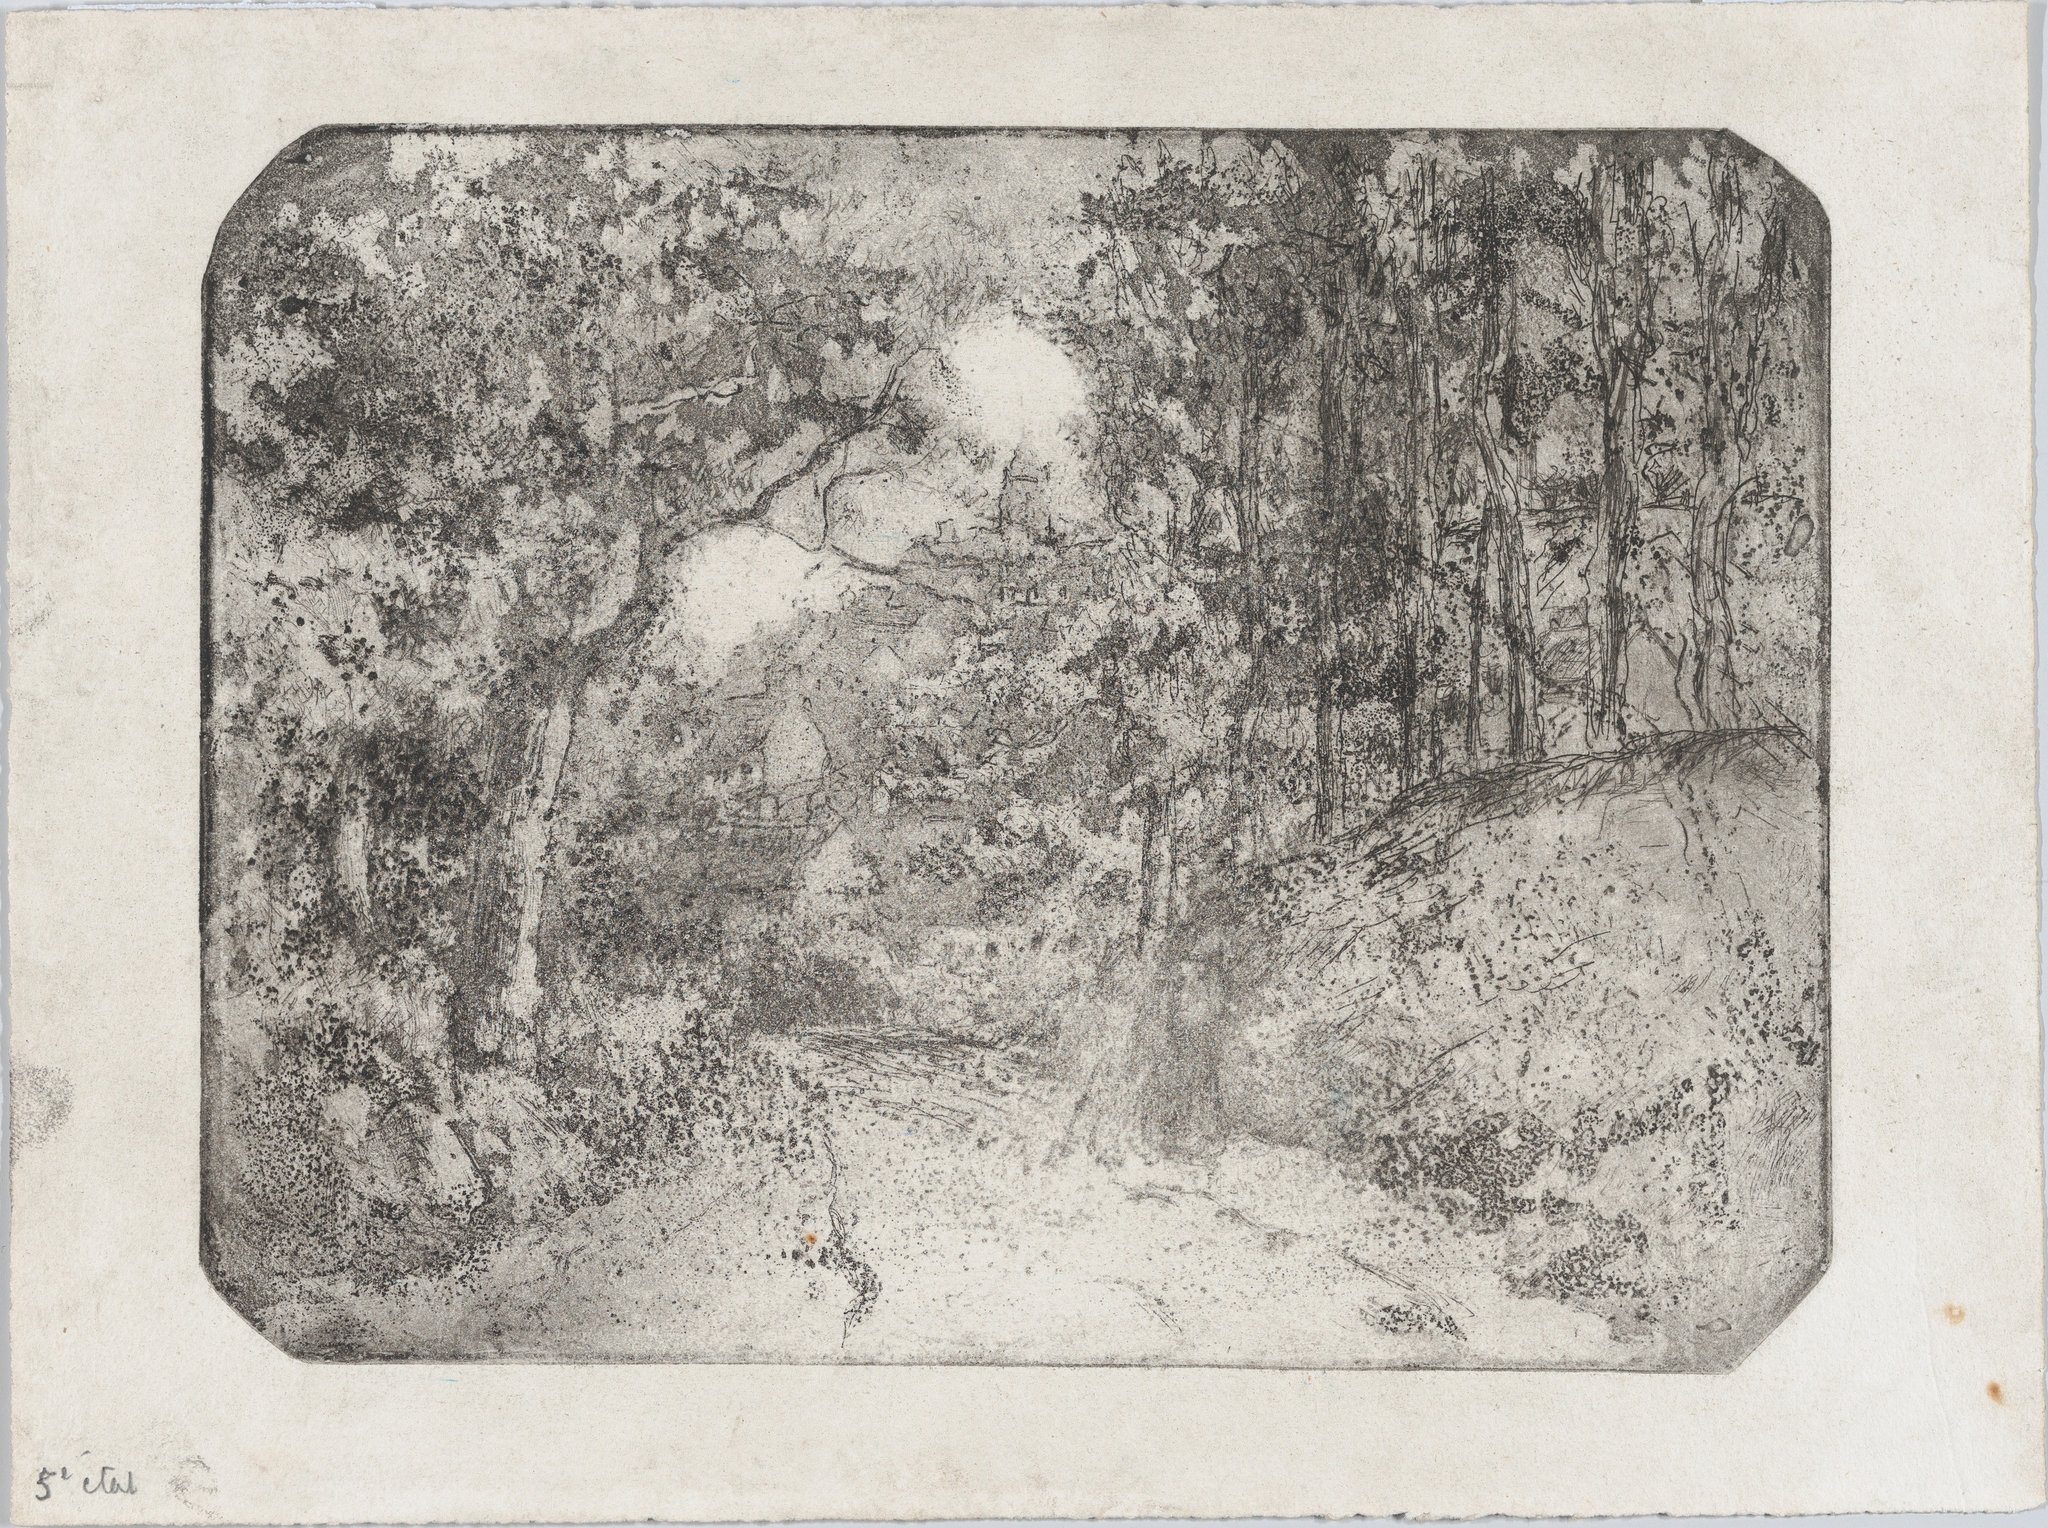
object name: print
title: Chemin sous bois à Pontoise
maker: camille pissarro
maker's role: artist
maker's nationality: french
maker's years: 1830-1903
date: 1879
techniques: aquatint, etching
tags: forests